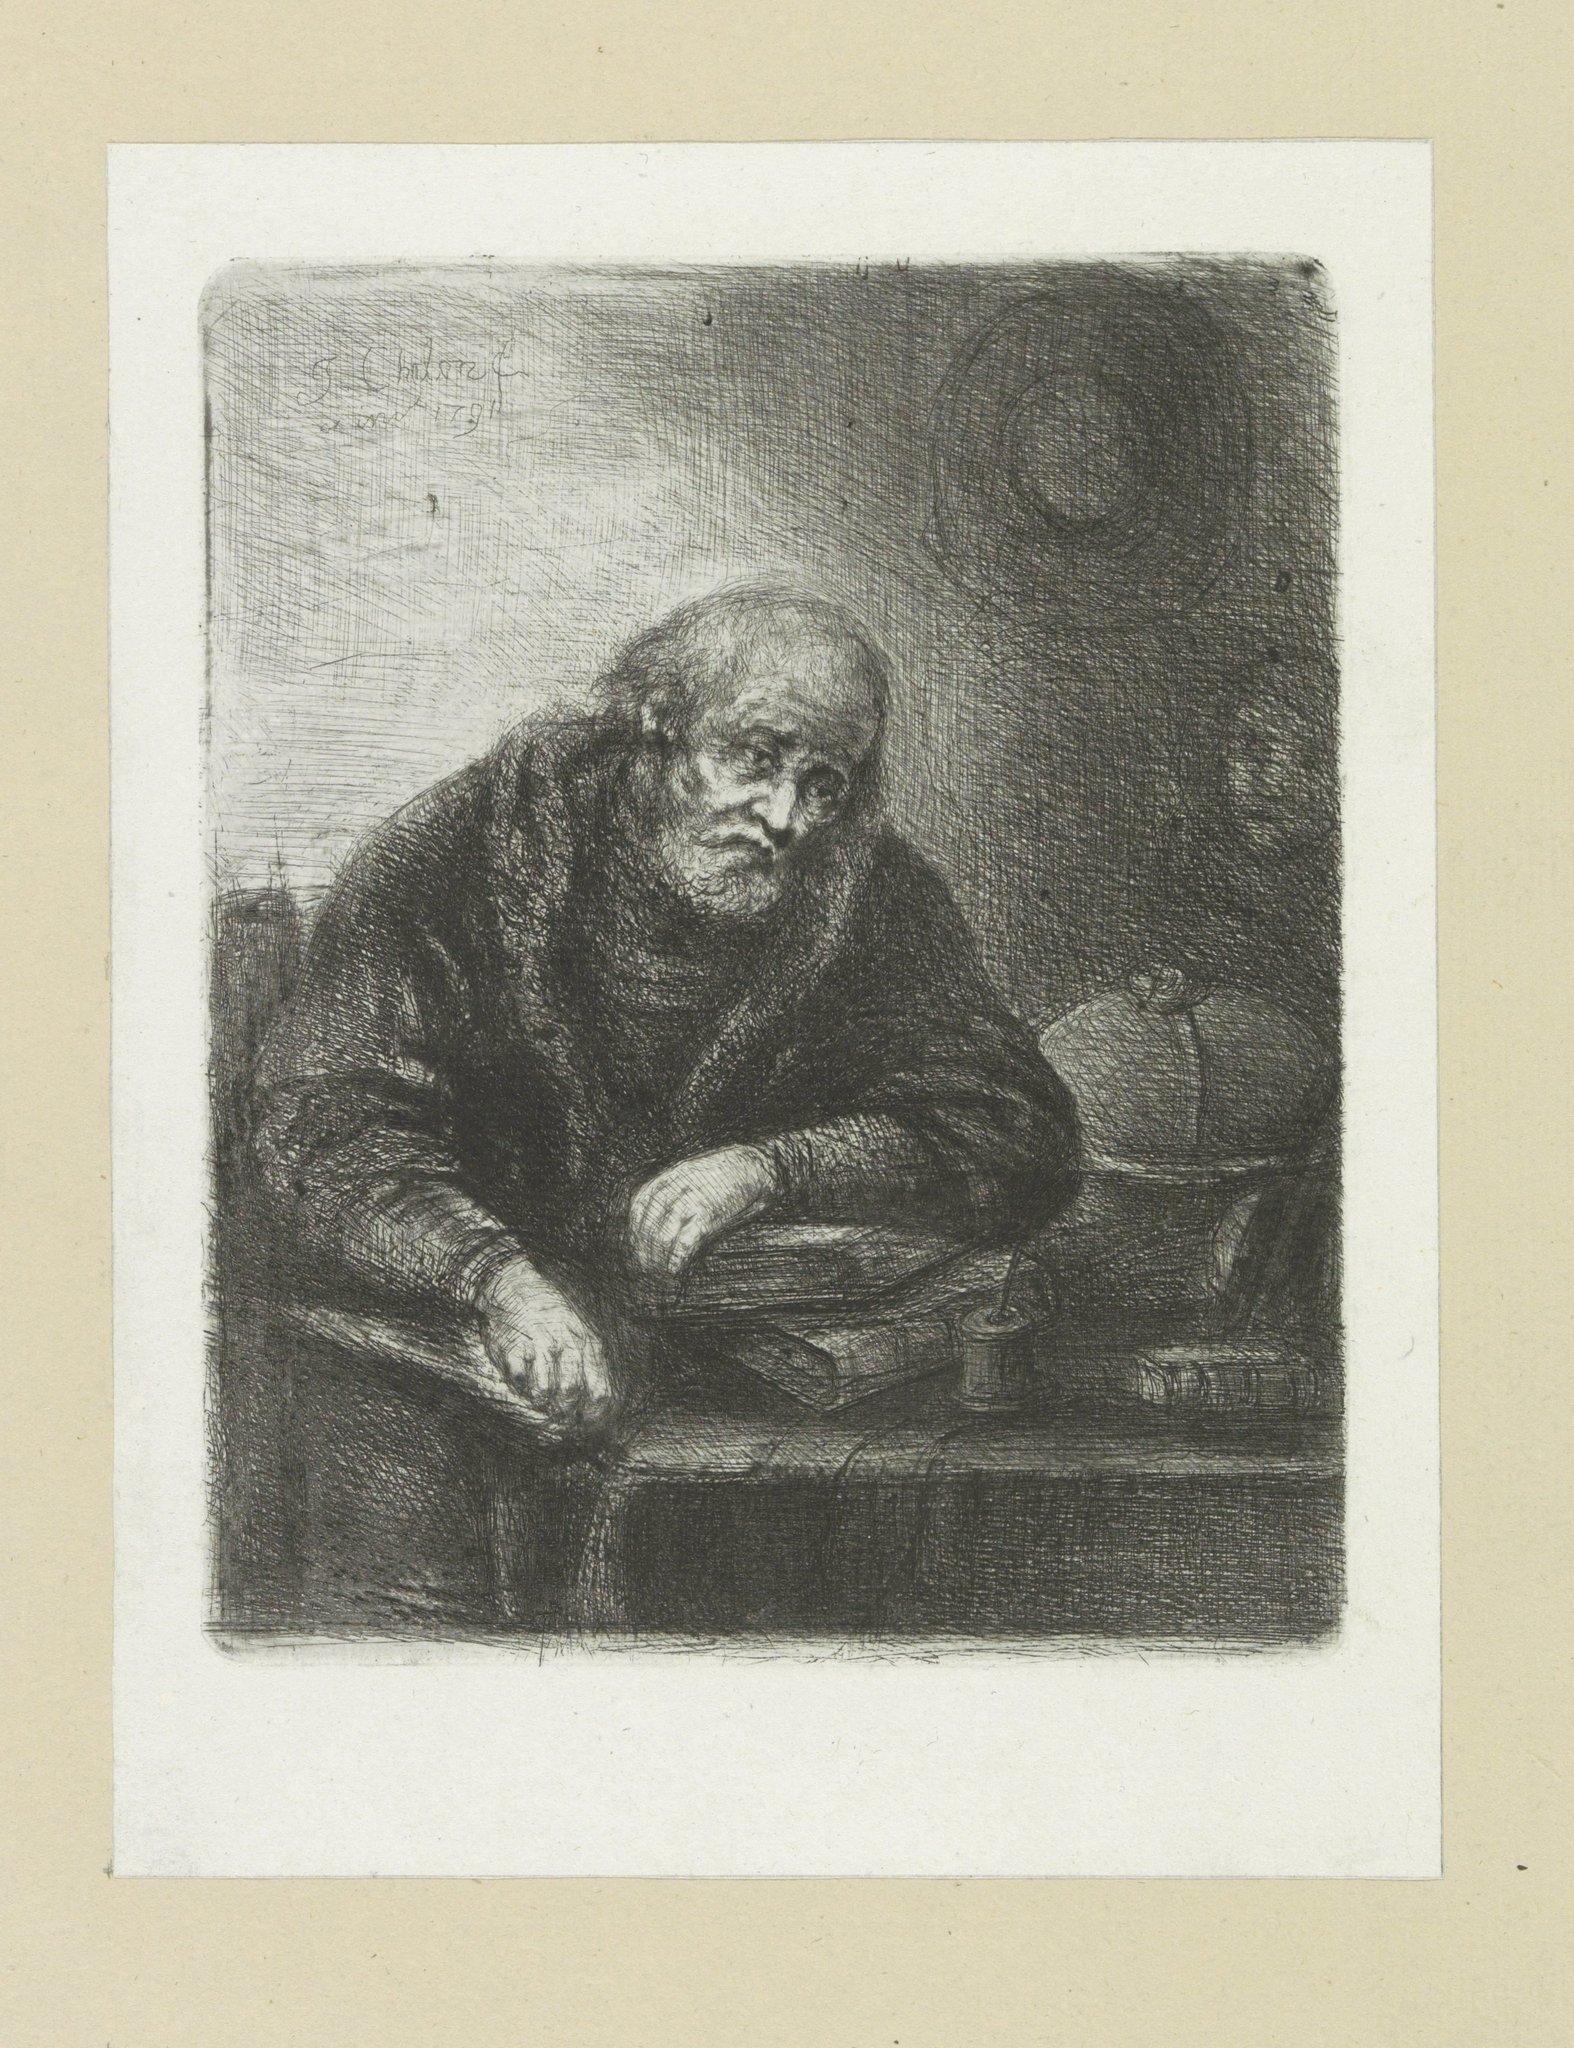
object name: album leaf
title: Oude man aan zijn bureau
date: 1791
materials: paper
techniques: drypoint, etching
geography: london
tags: writing-table, writing-desk, ink-well, globe, morphology of human expression (+ old male (human being))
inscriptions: collector's mark: ‘B’, collector's mark: ‘RIJKS / MUSM’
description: Een oude man. Hij zit in een stoel voor zijn bureau. Op zijn bureau boeken, schrijfgerief en een wereldglobe. De prent maakt deel uit van een album.